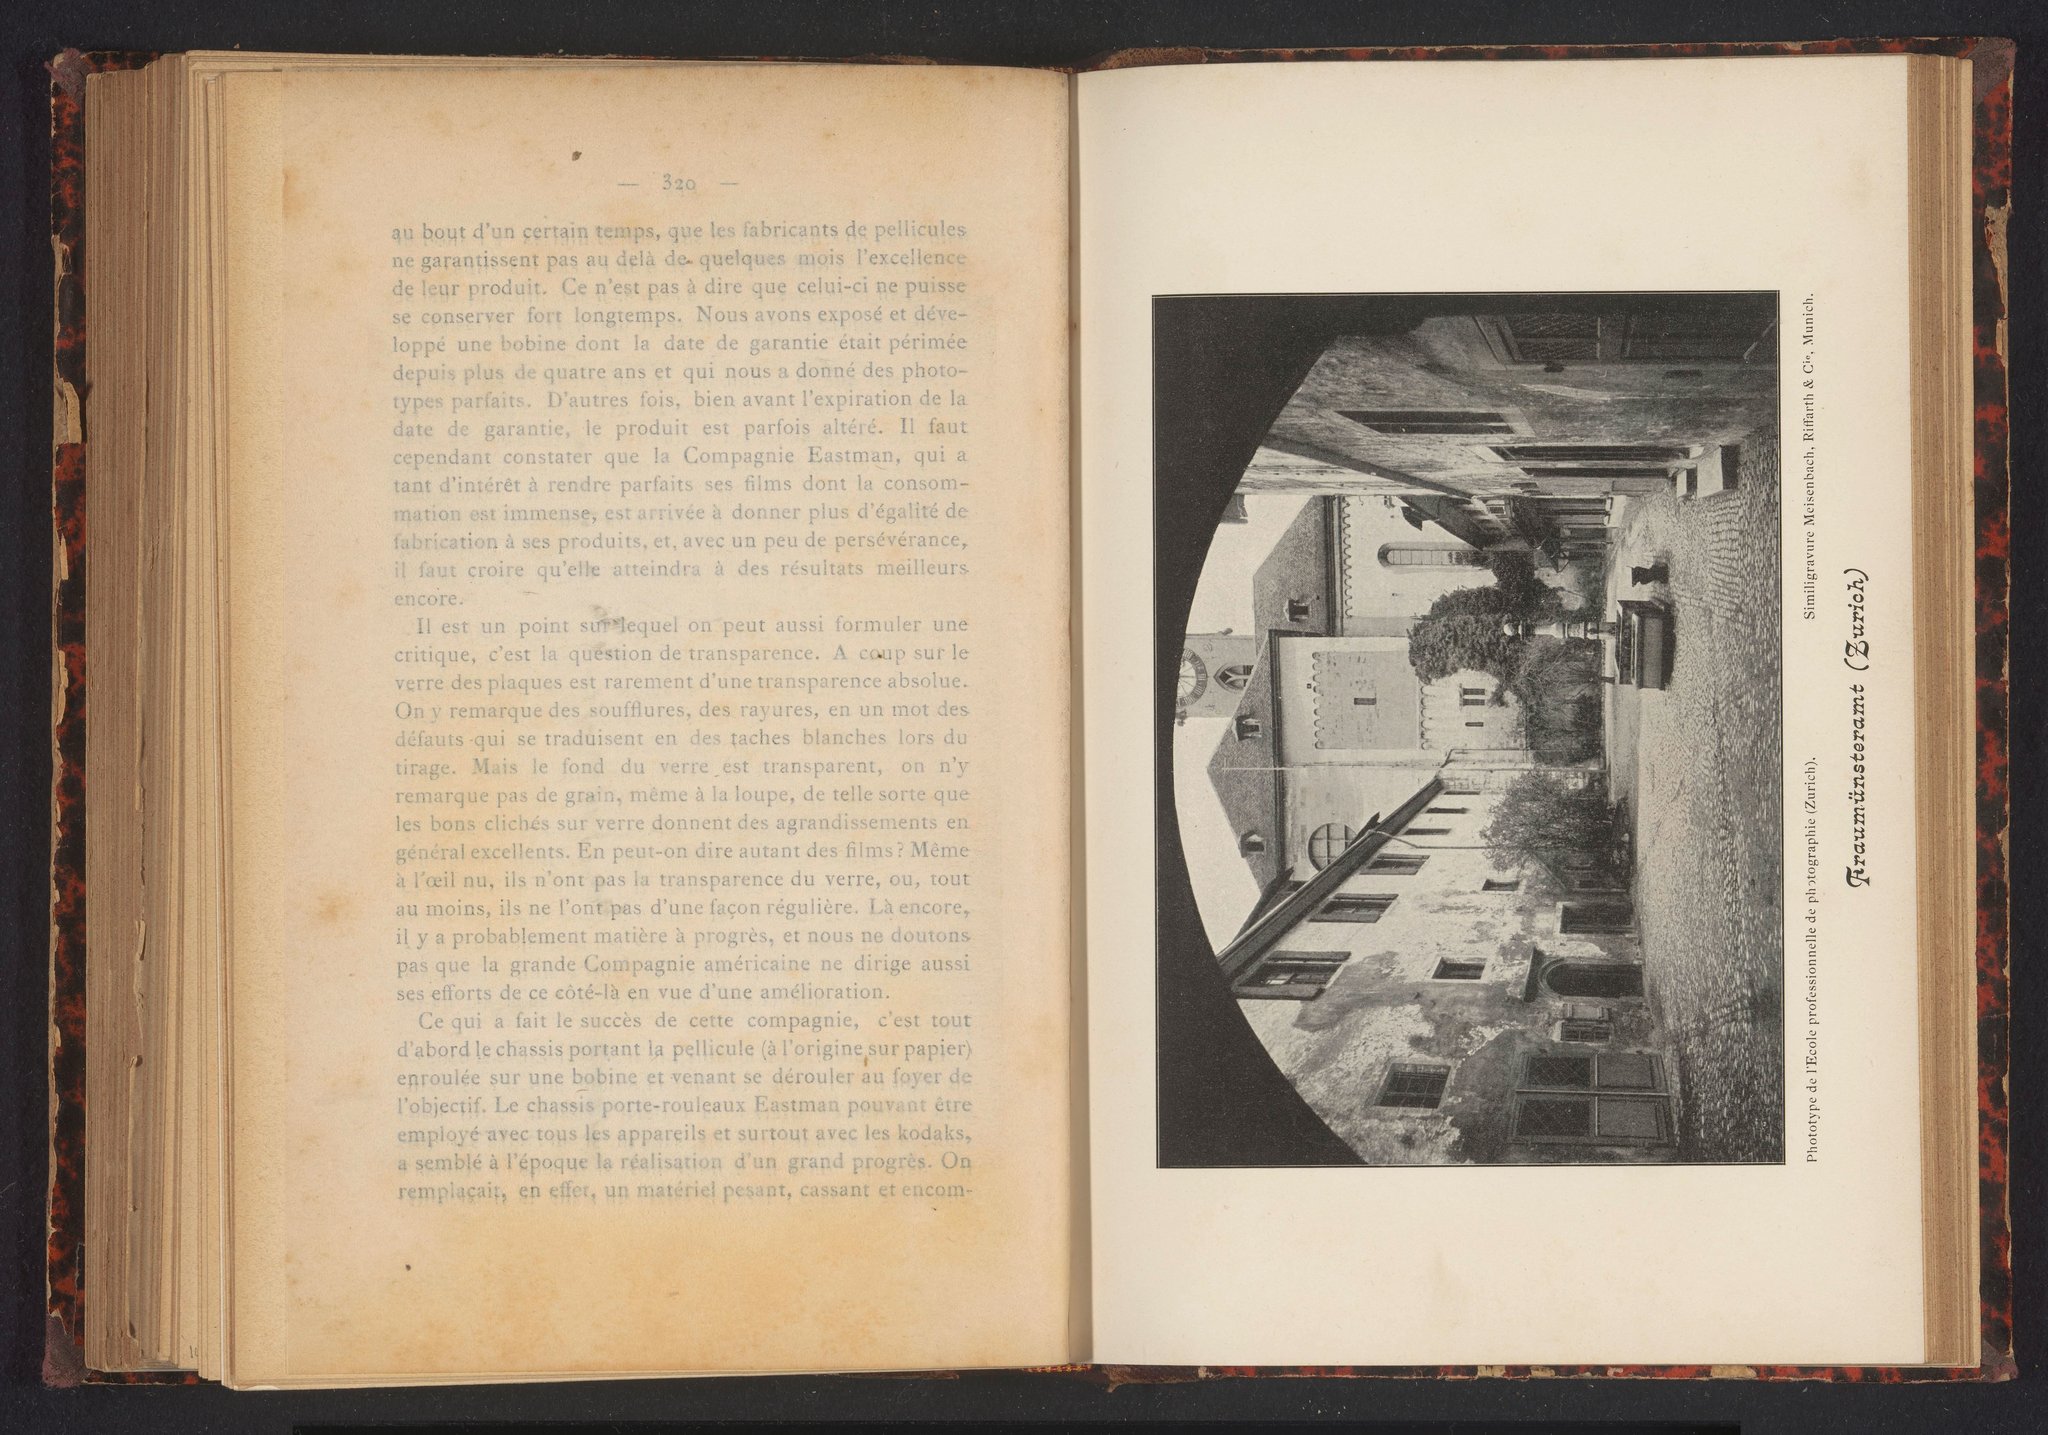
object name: photomechanical print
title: Binnenplaats van het Fraumünster klooster te Zurich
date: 1895-1900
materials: paper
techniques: autotype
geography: munich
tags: cloisters ~ monastery, courtyard